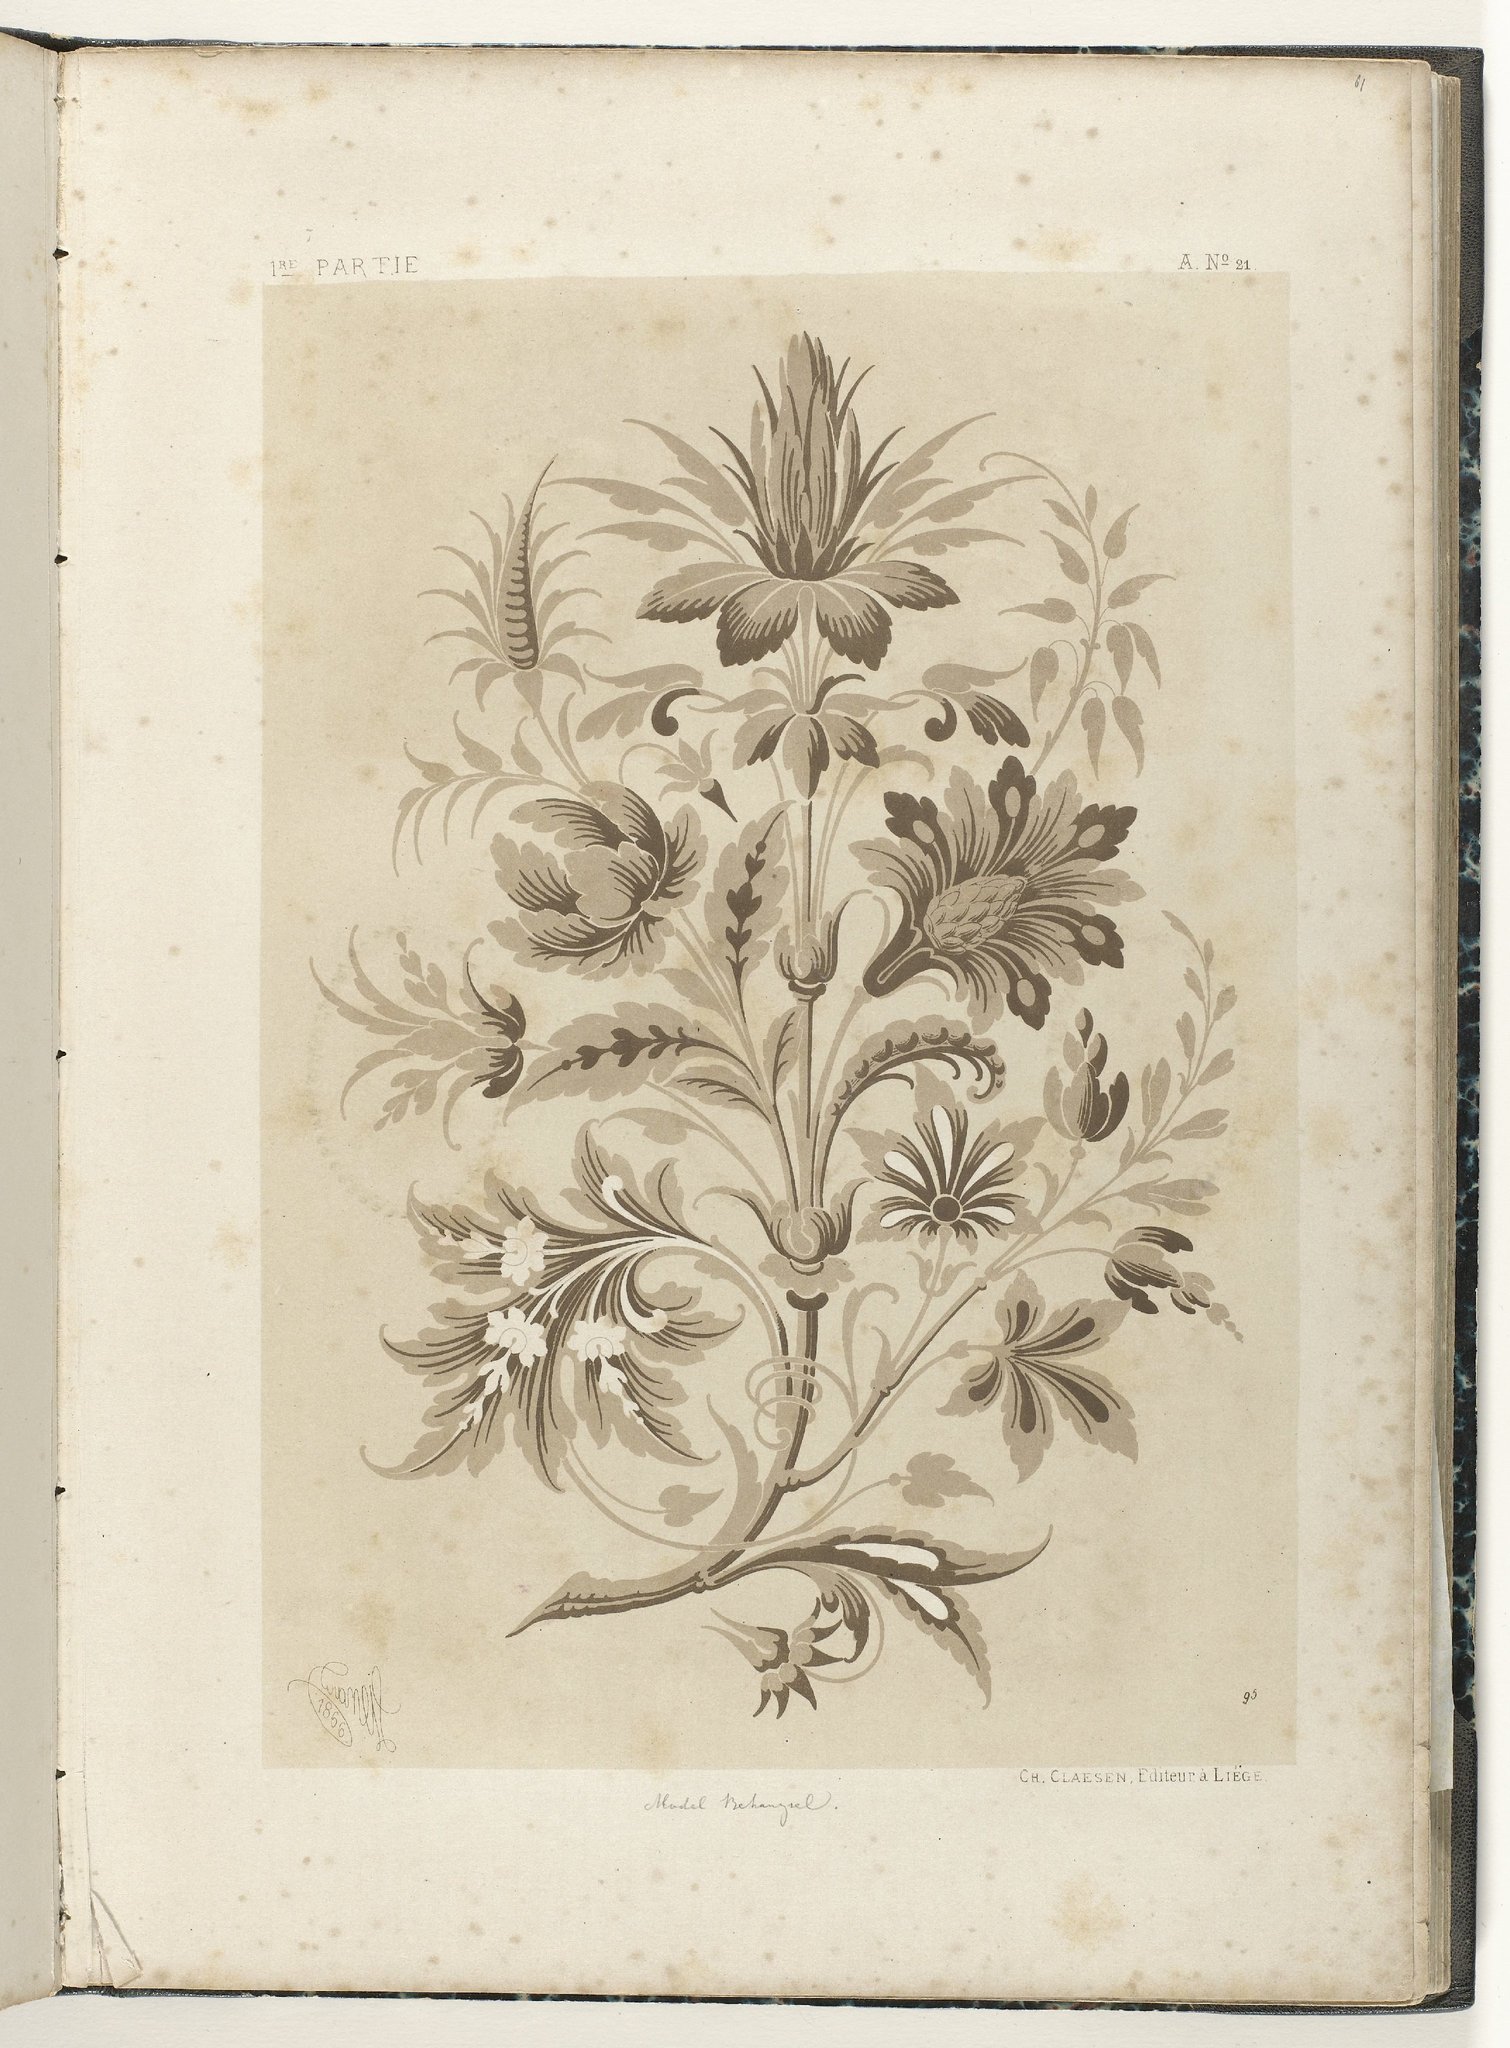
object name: print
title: Tak met gestileerde bladeren en bloemen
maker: michel liénard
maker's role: print maker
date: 1866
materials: paper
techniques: tone lithography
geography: liège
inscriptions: annotation: ‘Model Behangsel.’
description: Linksboven: 1re partie, rechtsboven: A. N° 21., rechtsonder: 95.